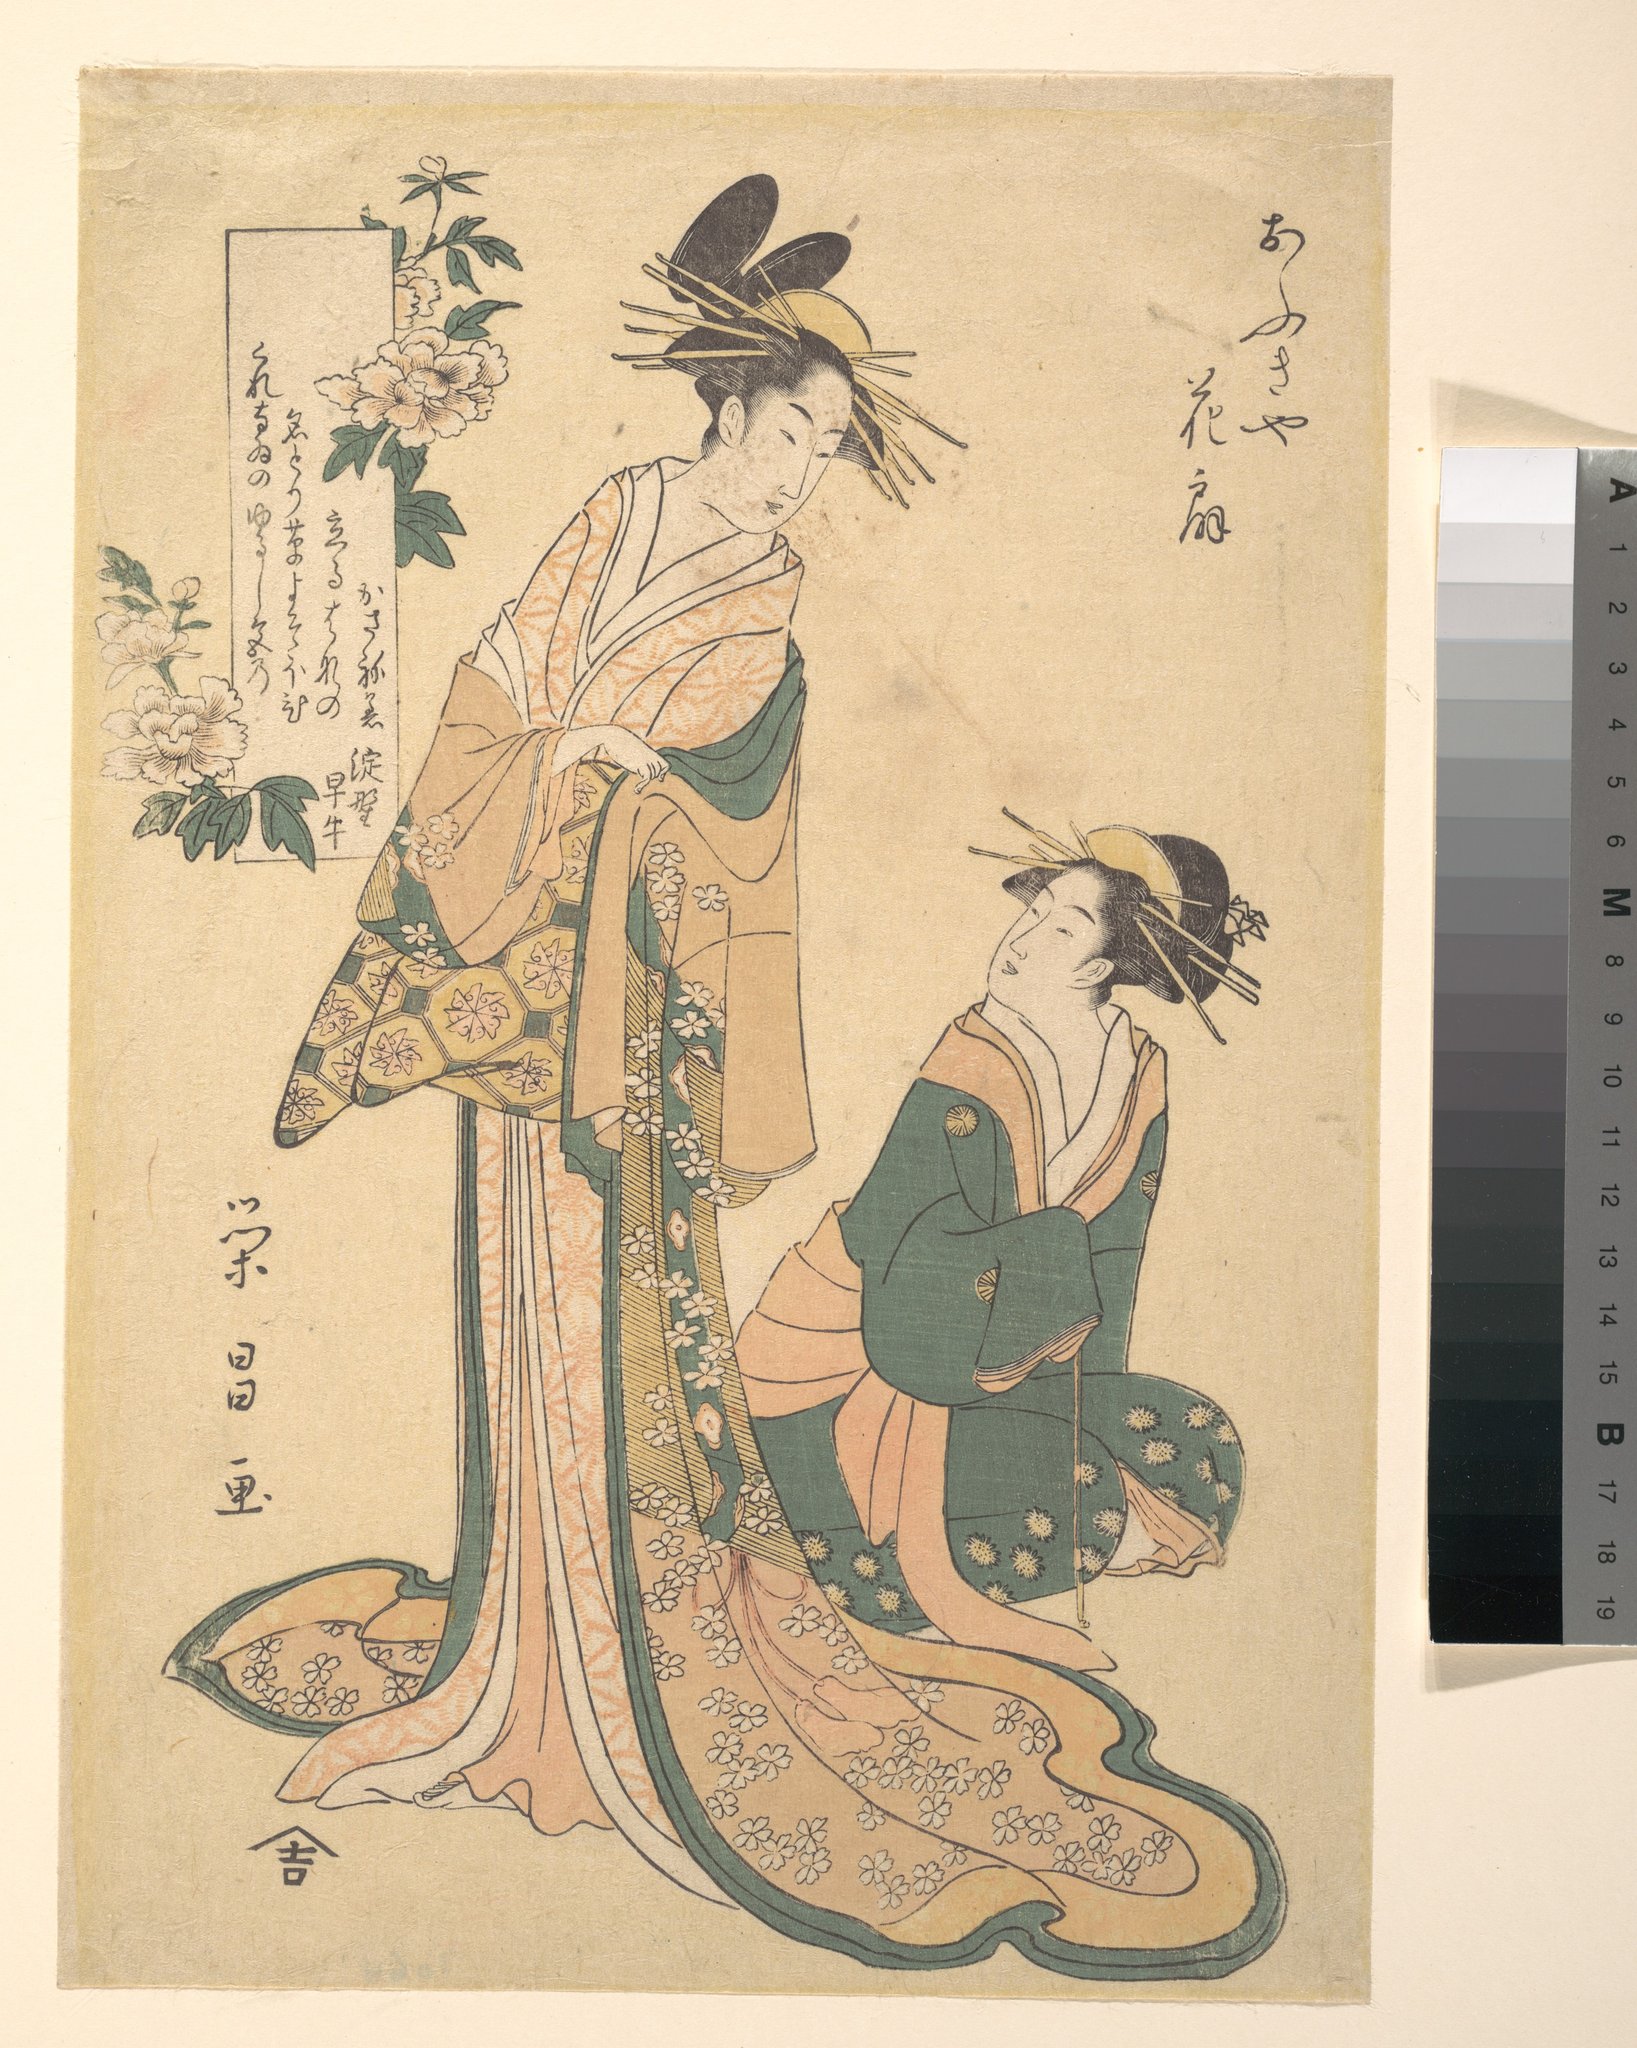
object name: print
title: Courtesan and Her Maid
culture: japanese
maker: chōkōsai eishō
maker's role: artist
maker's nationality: japanese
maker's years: 1793-1799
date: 1615-1868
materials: ink, paper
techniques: woodblock print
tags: women,servants